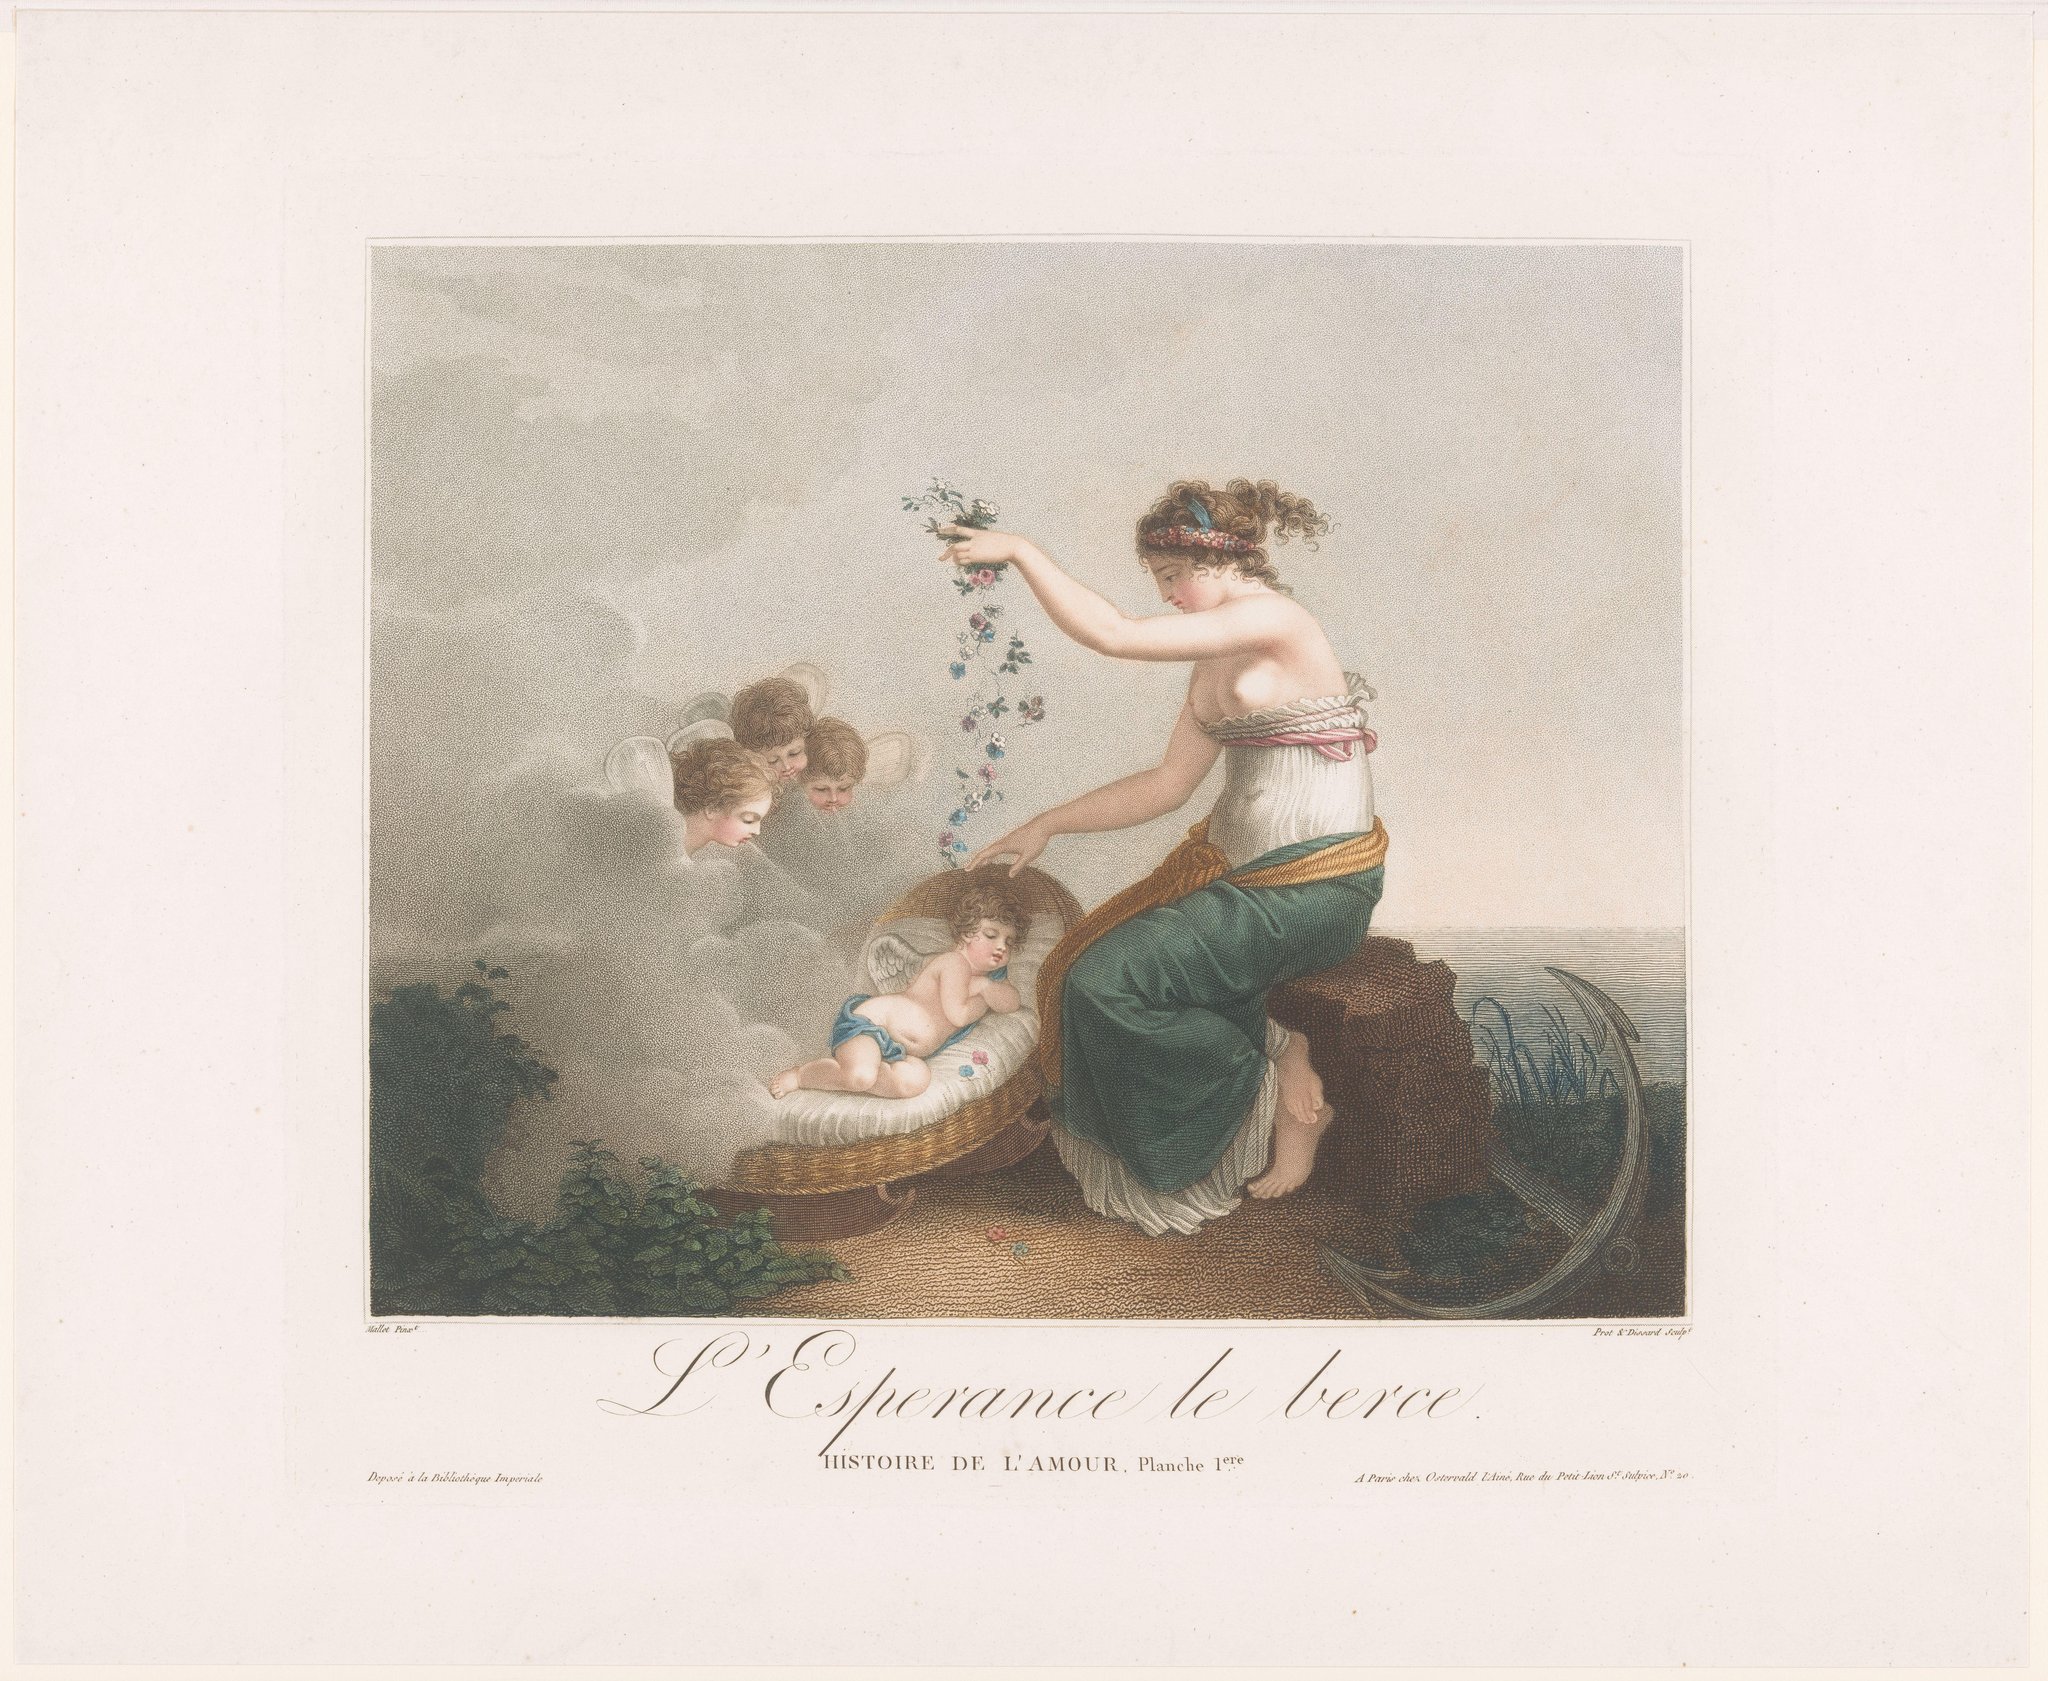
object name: print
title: Personificatie van Hoop (Spes) wiegt een Amor in slaap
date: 1817-1837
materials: paper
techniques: etching, hand coloring, lithography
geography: paris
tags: cradle, crib, cupids: 'amores', 'amoretti', 'putti', spes as roman personification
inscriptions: collector's mark: Lugt 2760, : ‘Déposé à la Bibliothèque Imperiale’, collector's mark: Lugt 2228